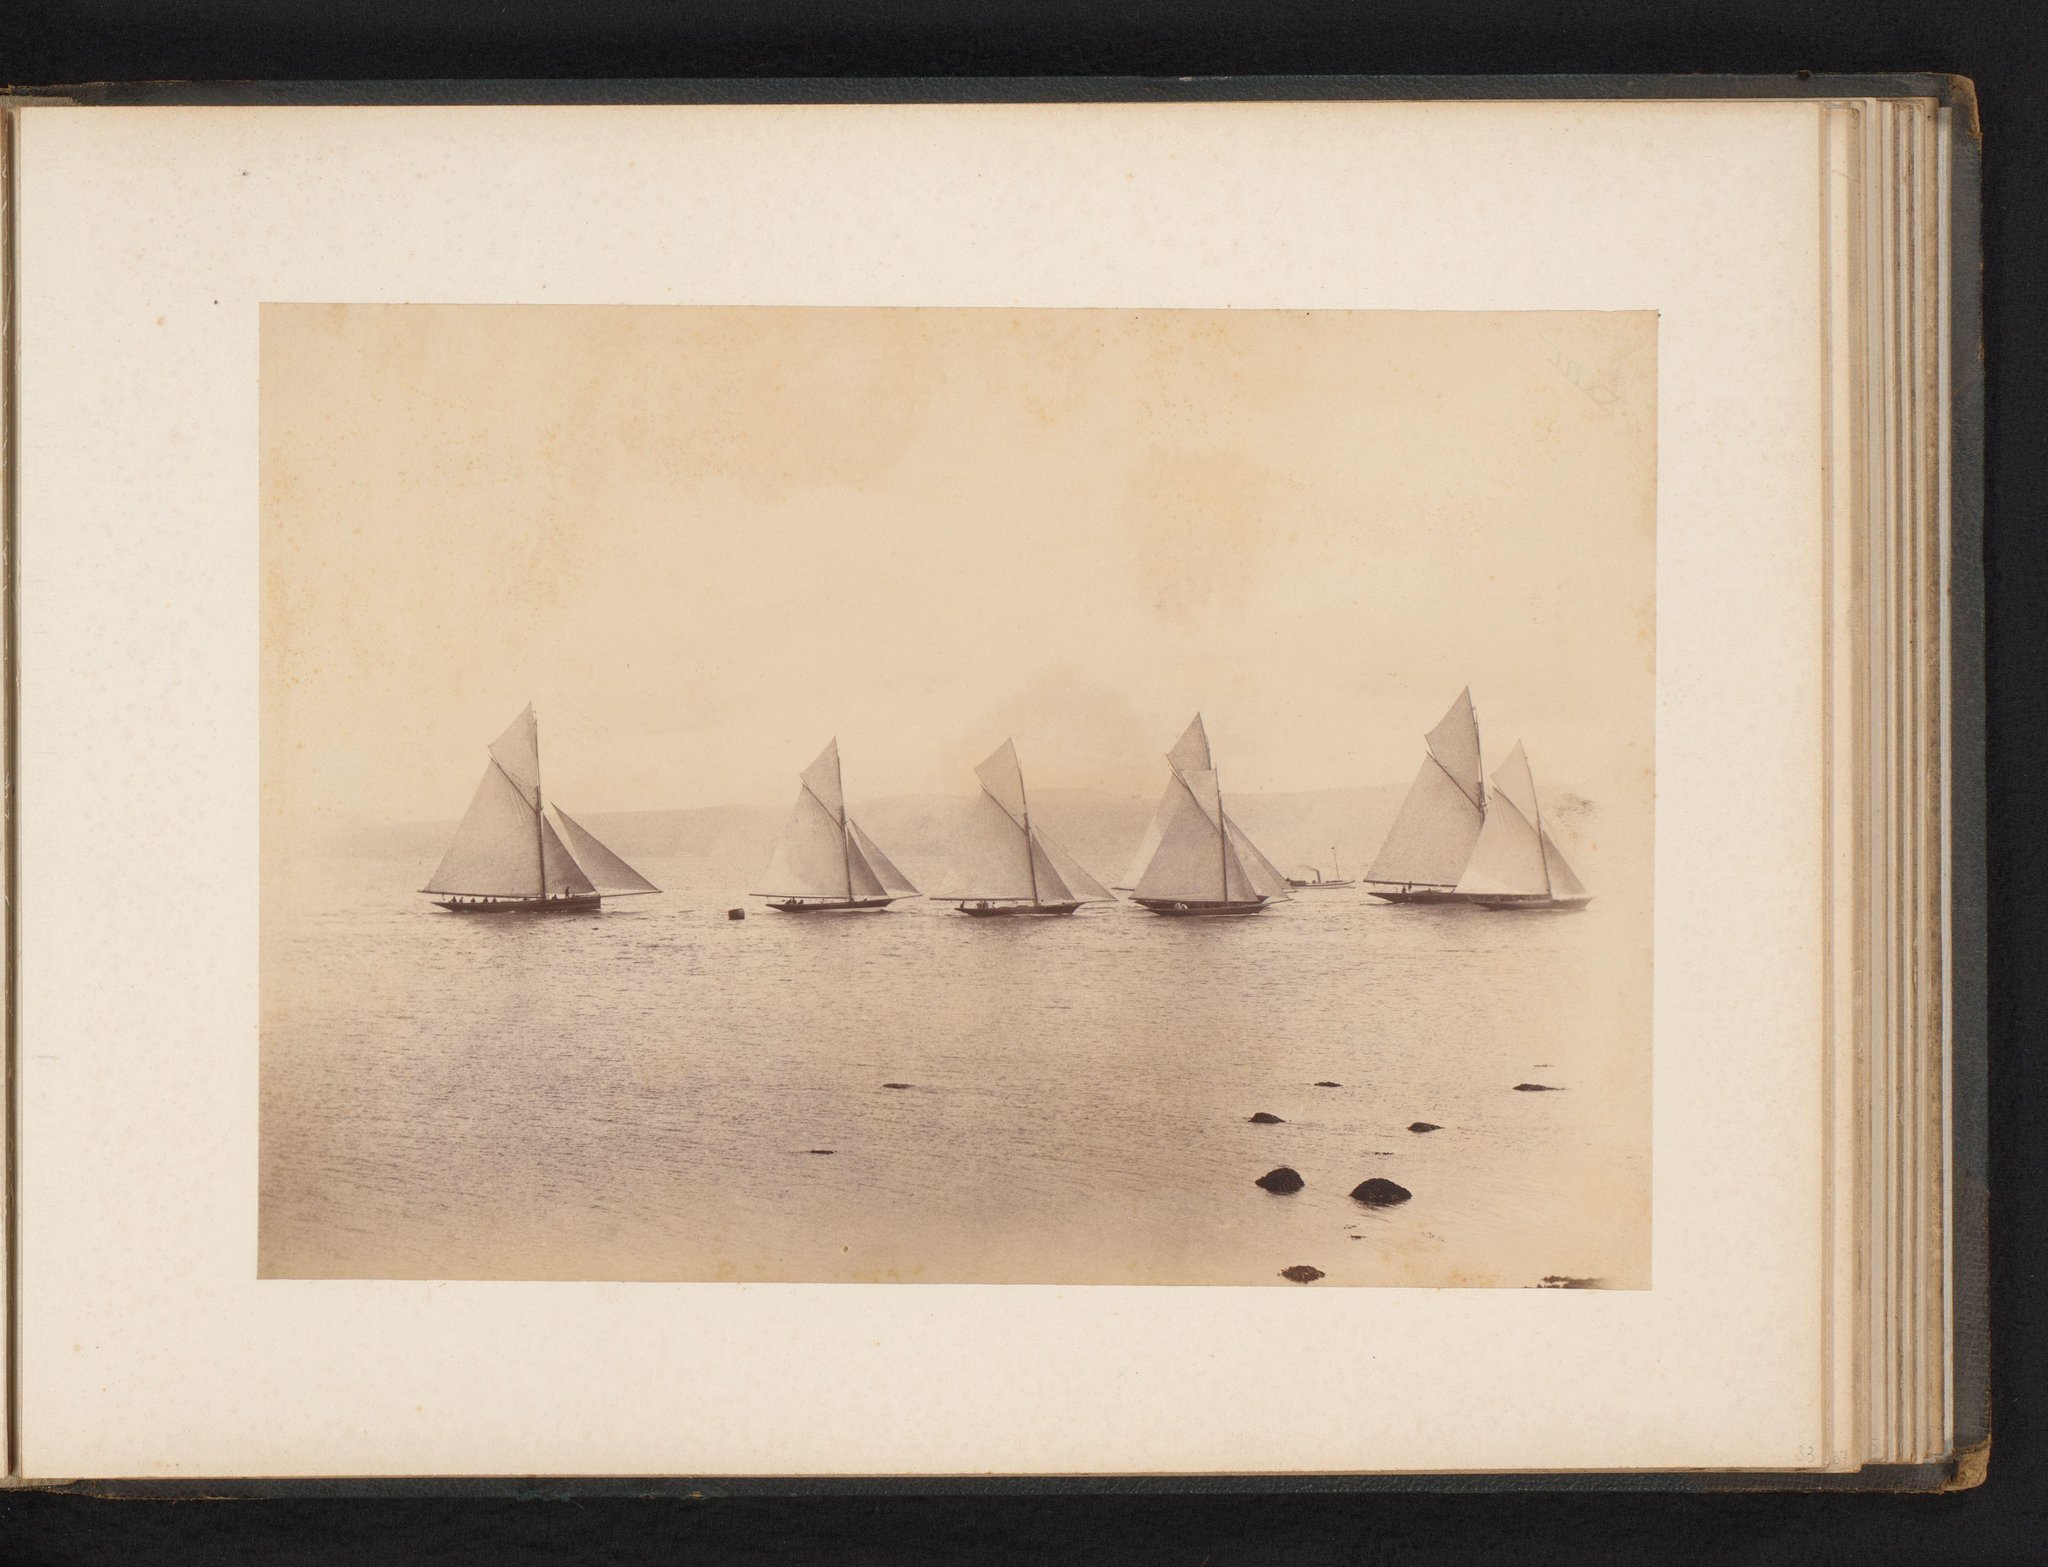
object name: photograph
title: Verschillende zeilschepen te water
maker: james adamson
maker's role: fotograaf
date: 1880-1900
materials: photographic support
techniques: albumen print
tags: sailing-ship, sailing-boat, landscapes with waters, waterscapes, seascapes (in the temperate zone)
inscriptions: check stamp: ‘Adamson, Rothesay.H.B’